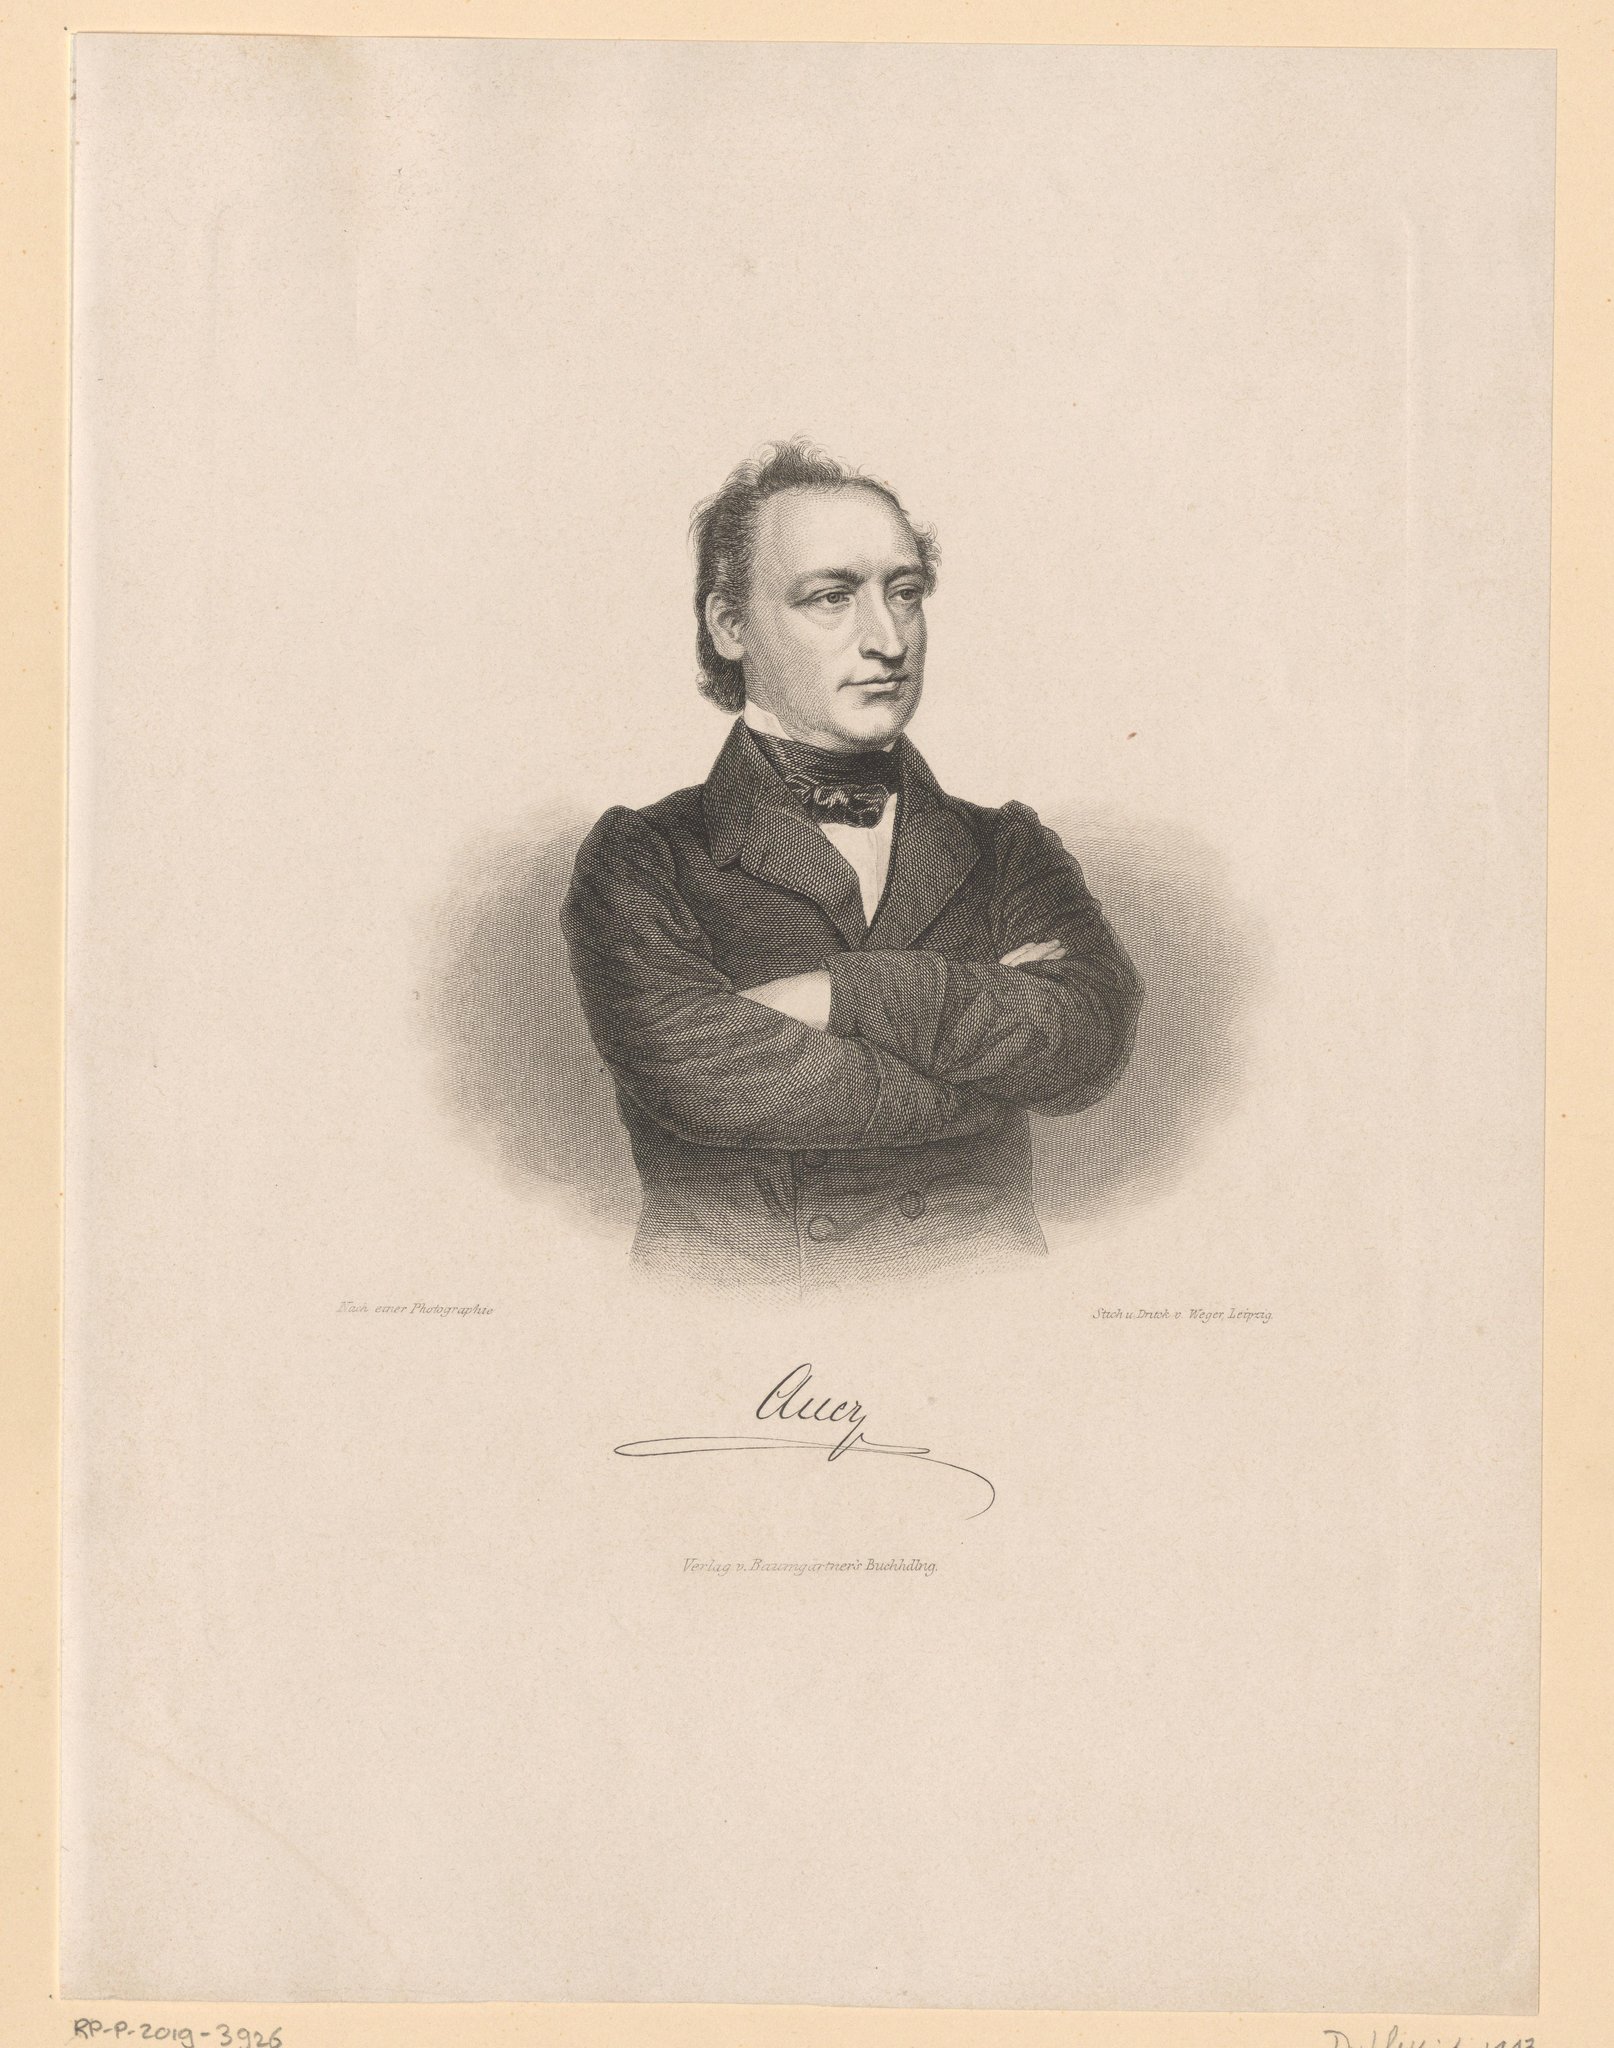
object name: print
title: Portret van Alois Auer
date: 1840-1892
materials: paper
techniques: engraving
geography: leipzig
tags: vienna, printer, alois auer, historical persons